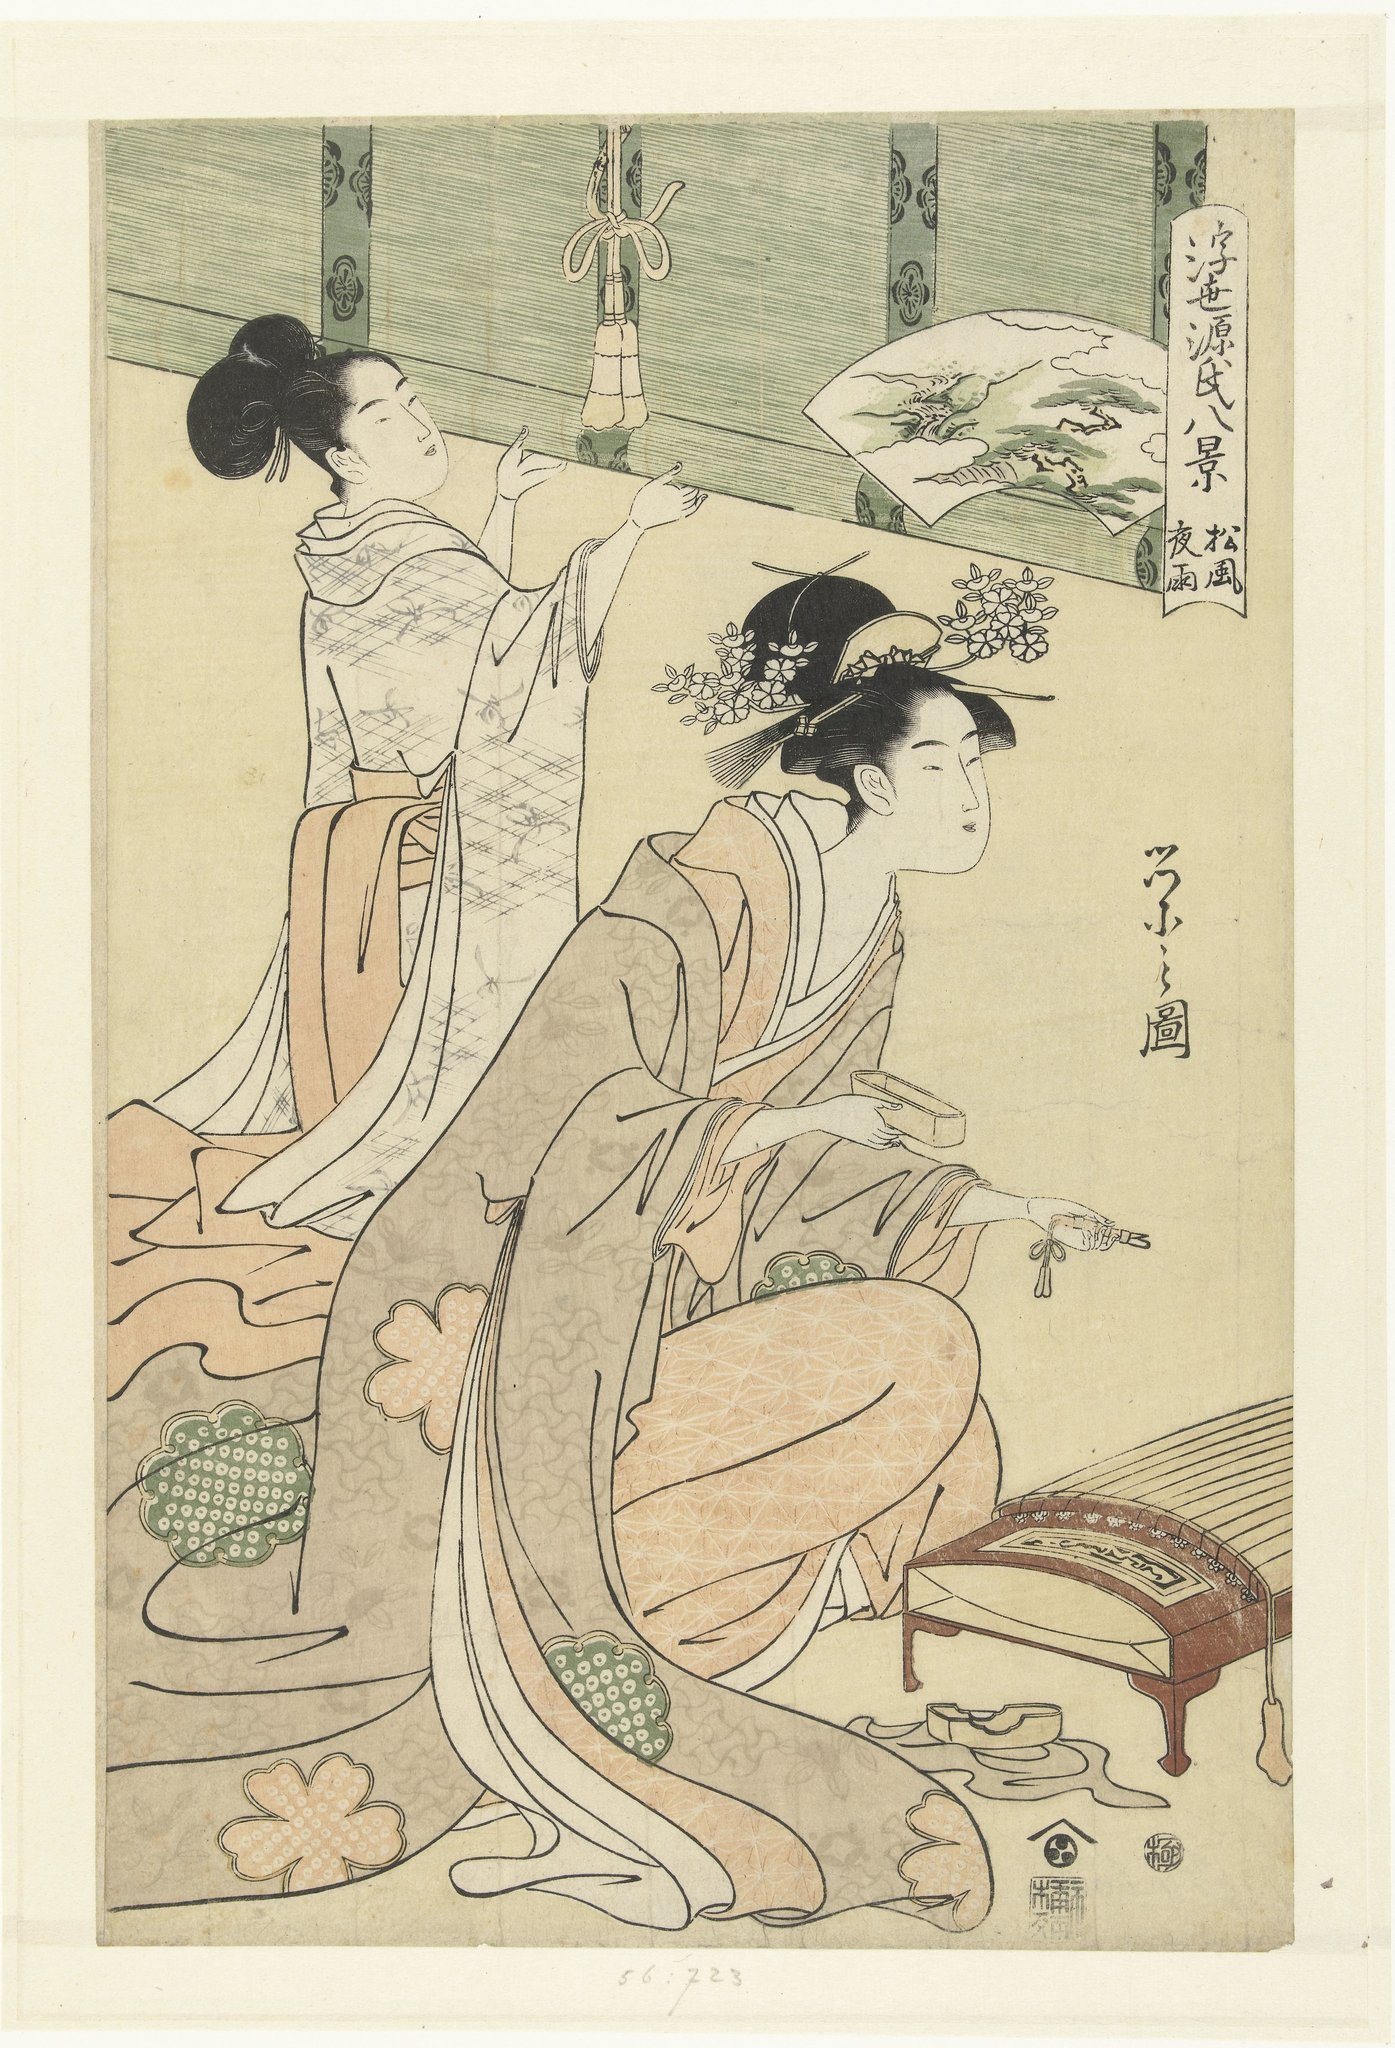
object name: print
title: Acht vlietende wereld gezichten van het Genji verhaal.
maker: hosoda eishi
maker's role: print maker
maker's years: 1756-1829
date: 1793-1797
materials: paper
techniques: woodcut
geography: tokyo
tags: curtains, string instruments (plucked)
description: Vrouw met voorwerp uit doosje in handen, knielend bij koto (Japans snaarinstrument); op de achtergrond meisje een bamboe gordijn oprollend. In waaiervormig cartouche rechtsboven landschap met waterval en pijnbomen tussen wolken.